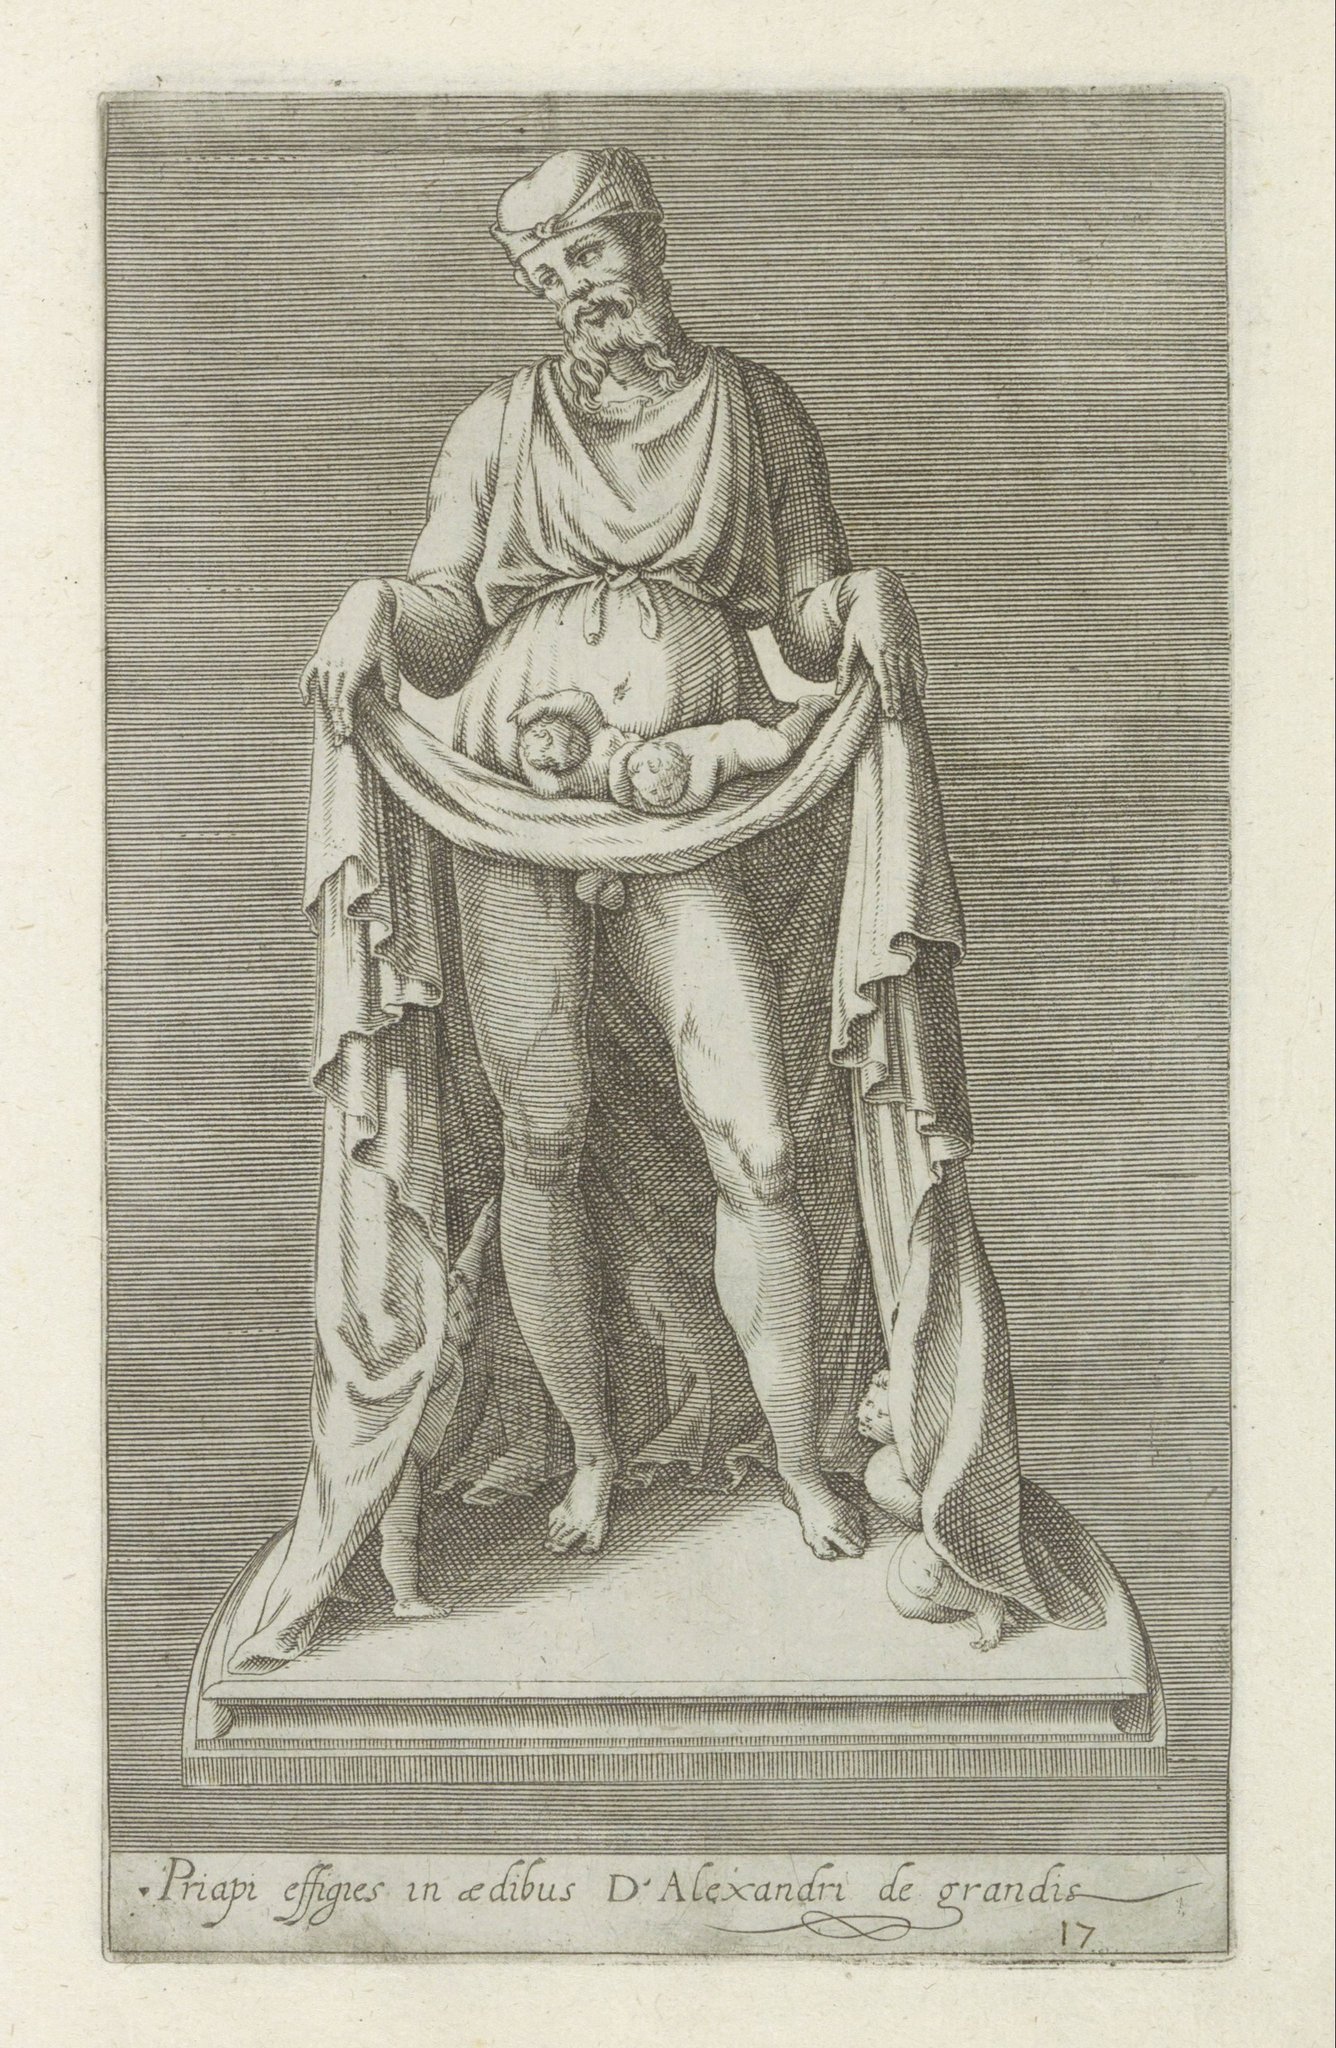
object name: print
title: Priapi effigies in aedibus d'Alexandri de grandis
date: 1584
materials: paper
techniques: engraving, intaglio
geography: italy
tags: (story of) priapus, piece of sculpture, reproduction of a piece of sculpture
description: Deze prent maakt deel uit van een set van 79 prenten (+ titelprent) met voorstellingen van antieke sculpturen in Rome.